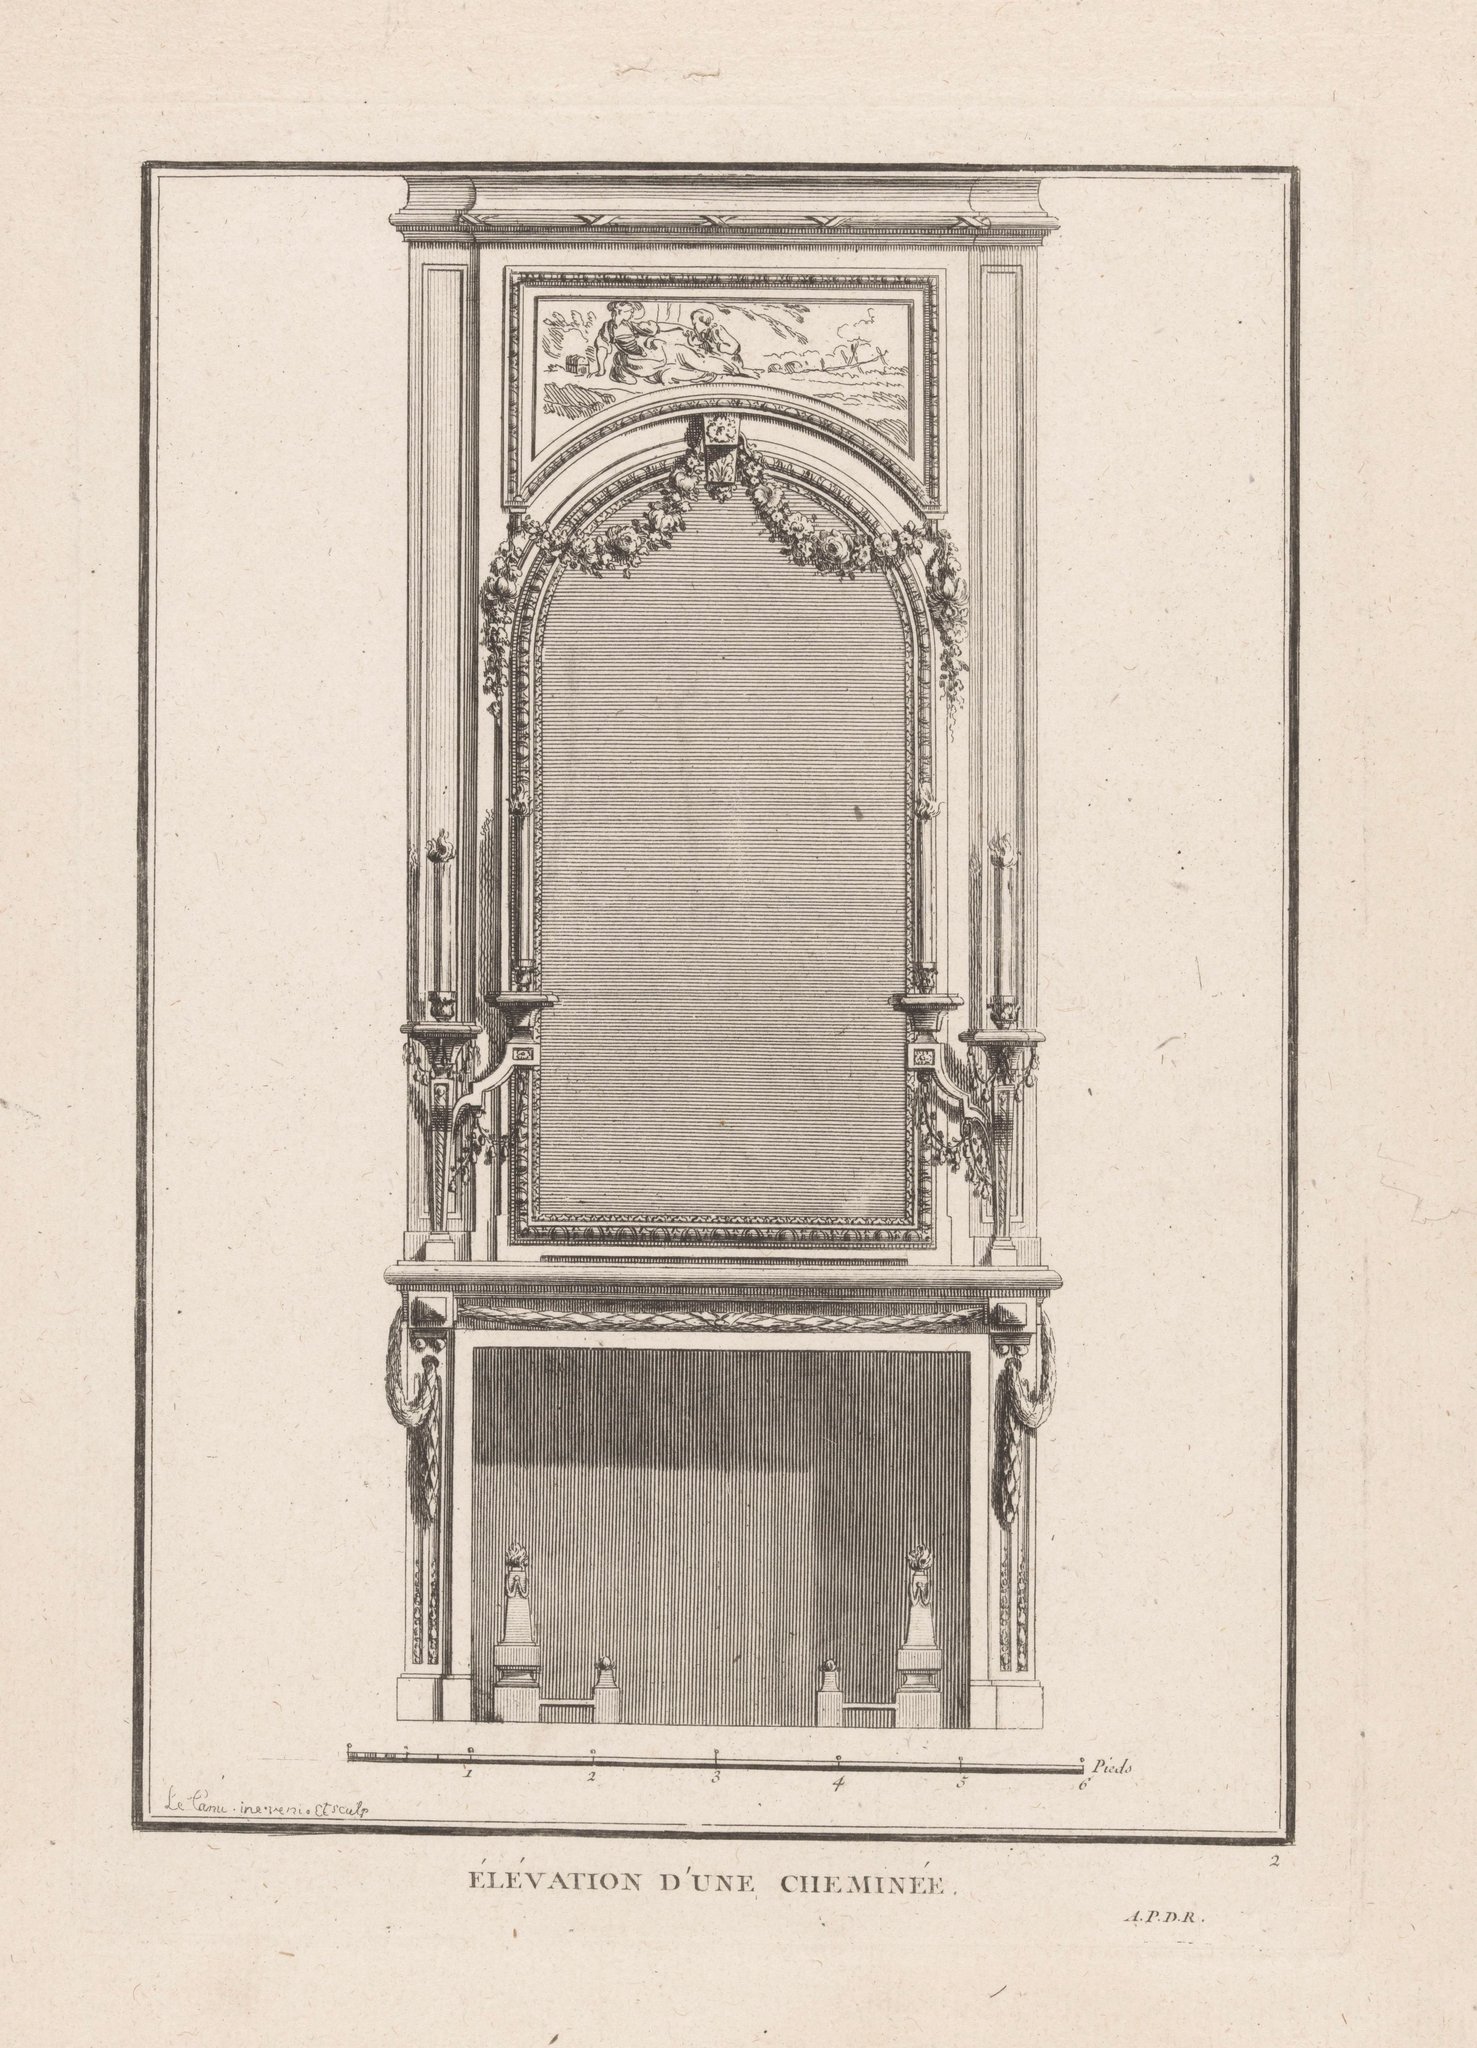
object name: ornament print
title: 4e Cahier Suite De Cheminées De Différentes Formes dans le Goût Antique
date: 1778-1782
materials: paper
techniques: etching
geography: paris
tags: chandelier, candelabrum, open hearth, fire-place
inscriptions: collector's mark: Lugt 2760, collector's mark: Lugt 2228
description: Een geornamenteerde schouw met twee tweearmige kandelaars, guirlandes en een paneel met figuren. In de haard staan twee vuurbokken.